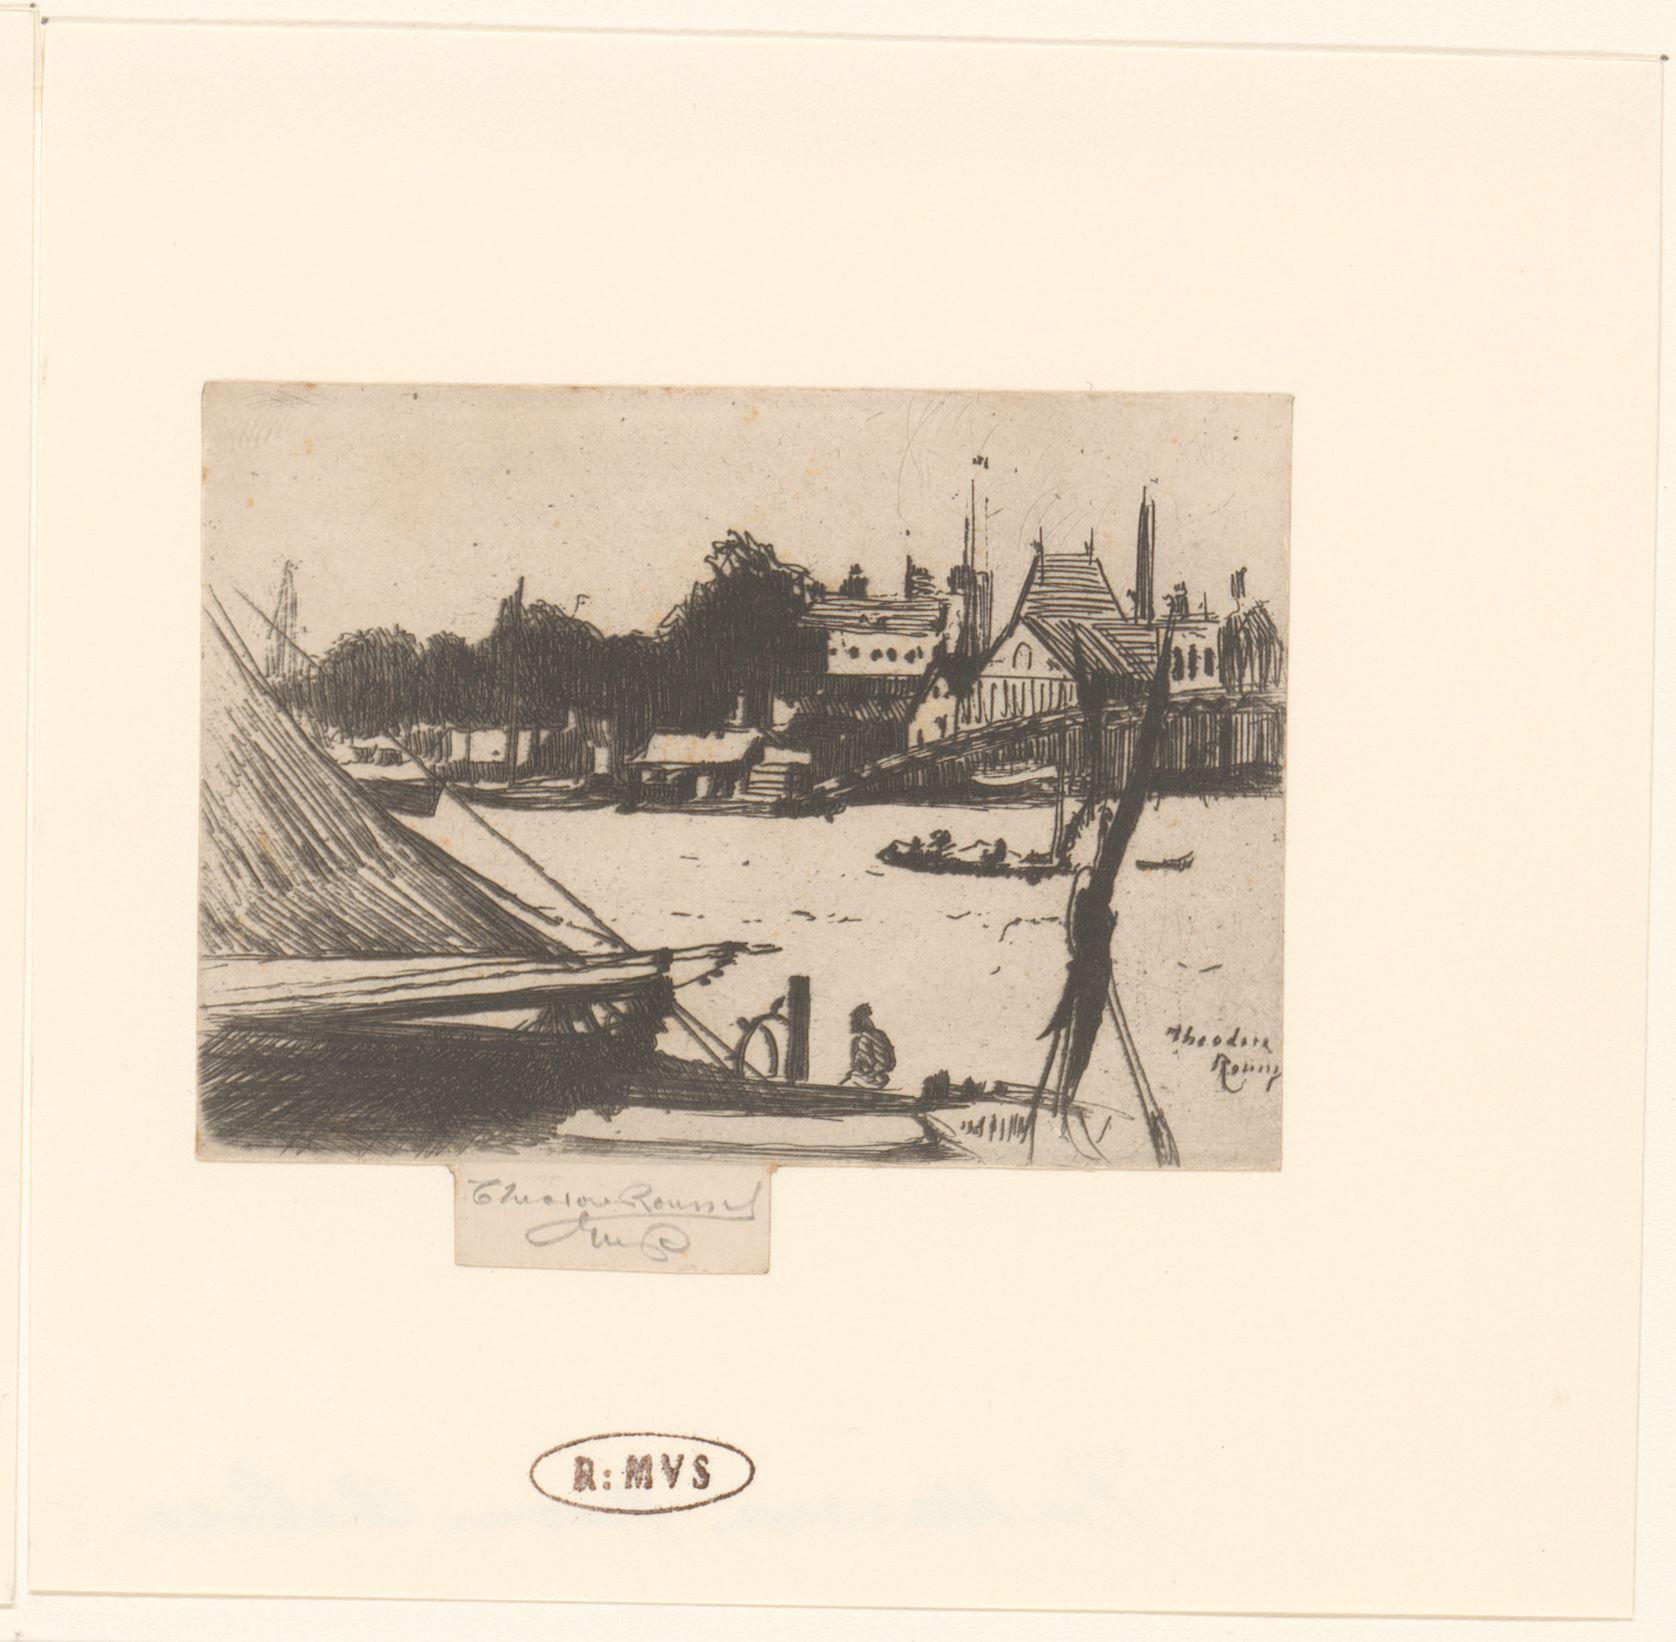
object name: print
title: Gezicht op rivier met boten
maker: théodore roussel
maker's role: print maker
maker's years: 1847-1926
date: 1888-1889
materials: paper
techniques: etching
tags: canals, waters (in city)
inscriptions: dedication: ‘To Hetty / Th R’, collector's mark: Lugt 2228